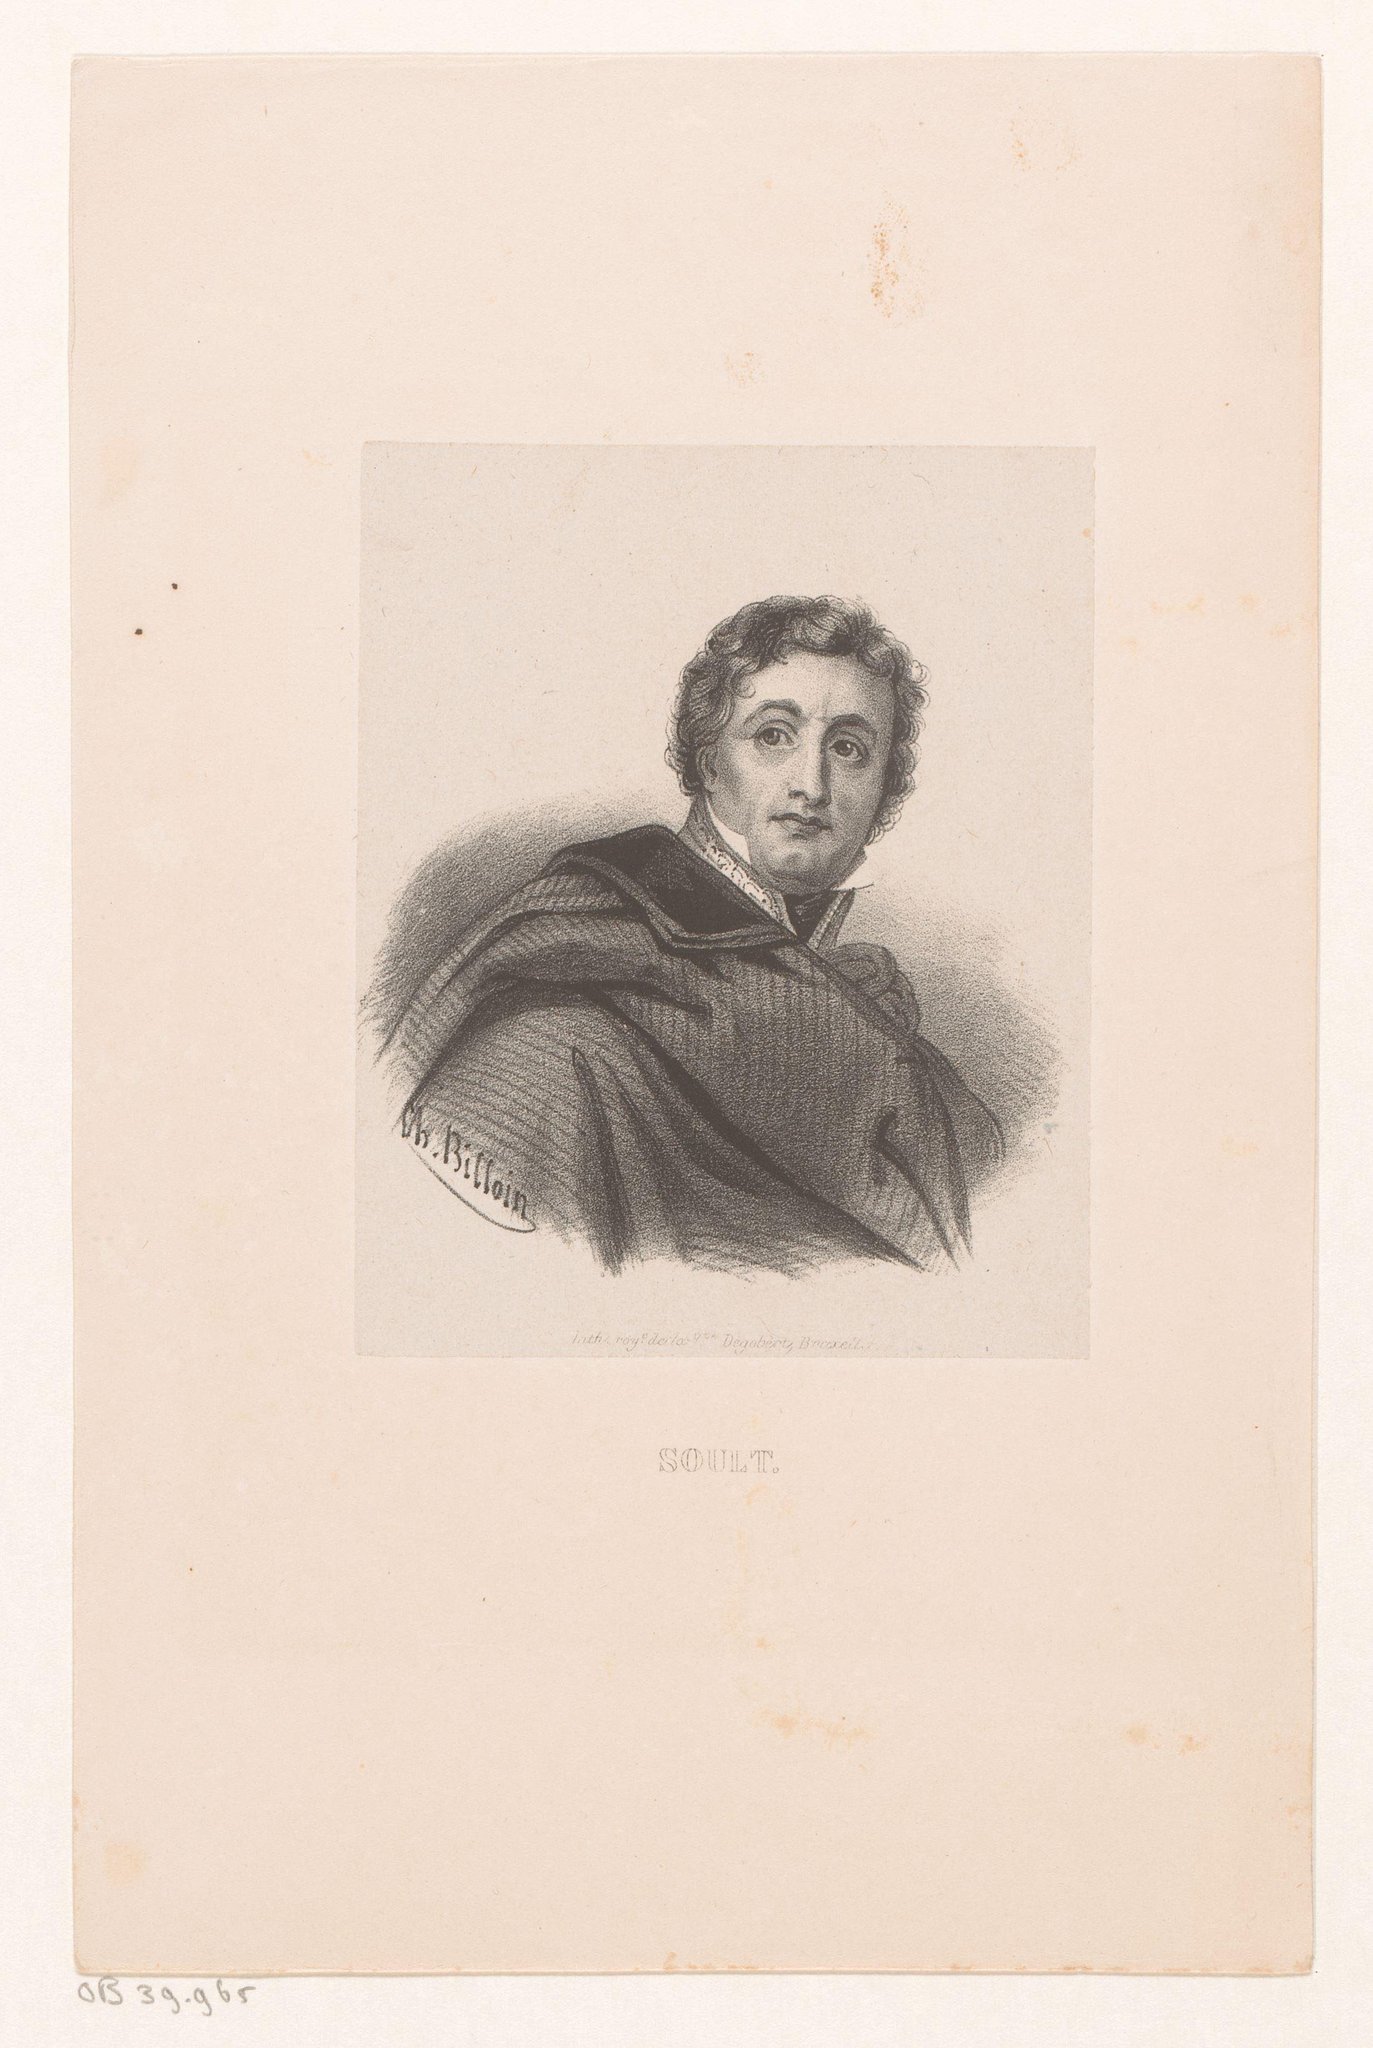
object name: print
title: Soult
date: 1823-1850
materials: paper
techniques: lithograph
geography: brussels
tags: adult man, historical persons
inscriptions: collector's mark: Lugt 2228